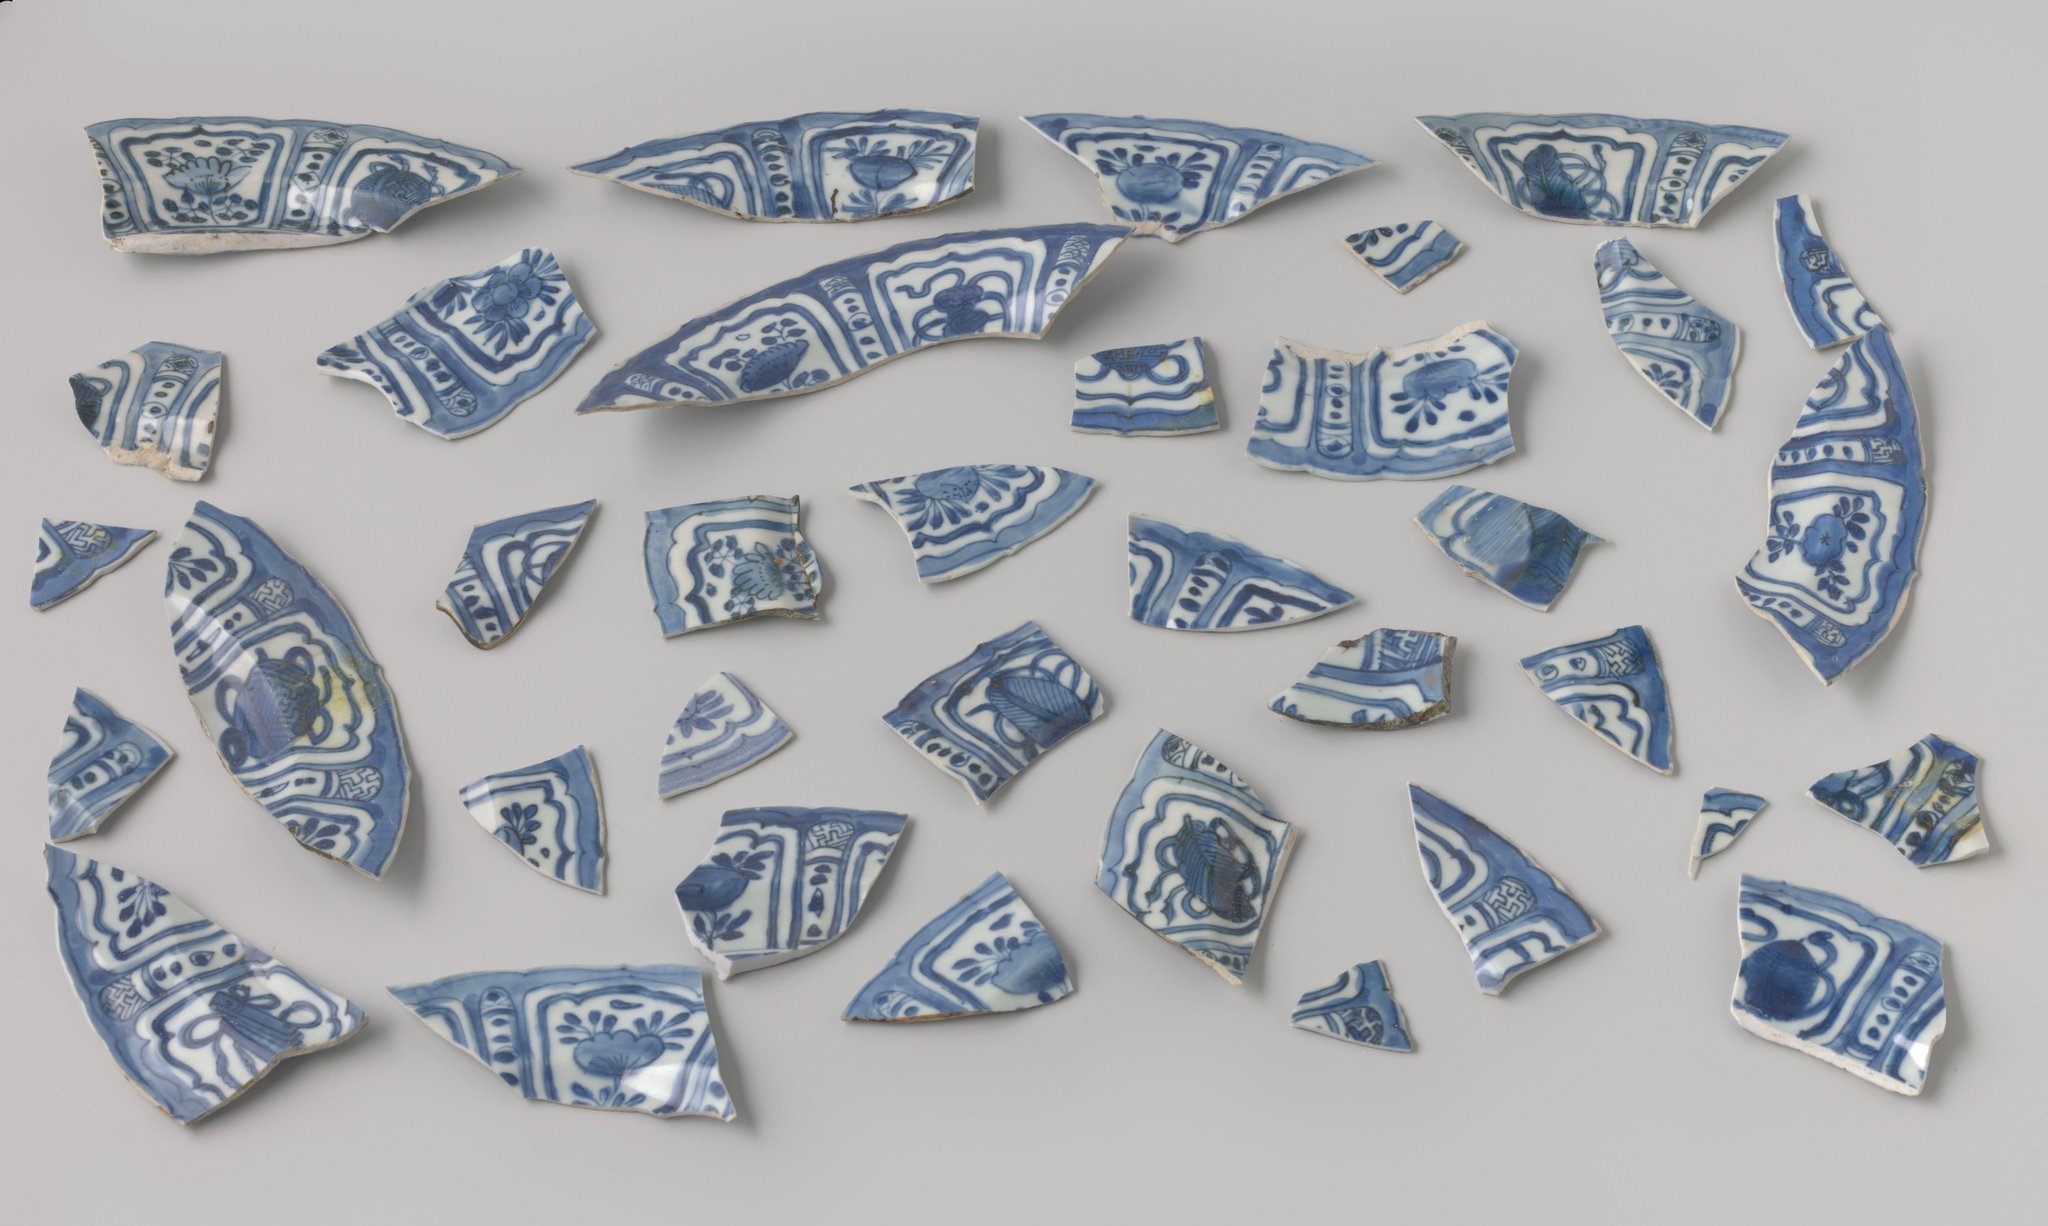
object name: plate dish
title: Scherven van borden uit V.O.C.-schip de 'Witte Leeuw'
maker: Anonymous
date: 1613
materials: bone china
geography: jingdezhen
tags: verenigde oostindische compagnie, sint-helena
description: Randfragmenten kraakporseleinen borden uit V.O.C.-schip de 'Witte Leeuw'.